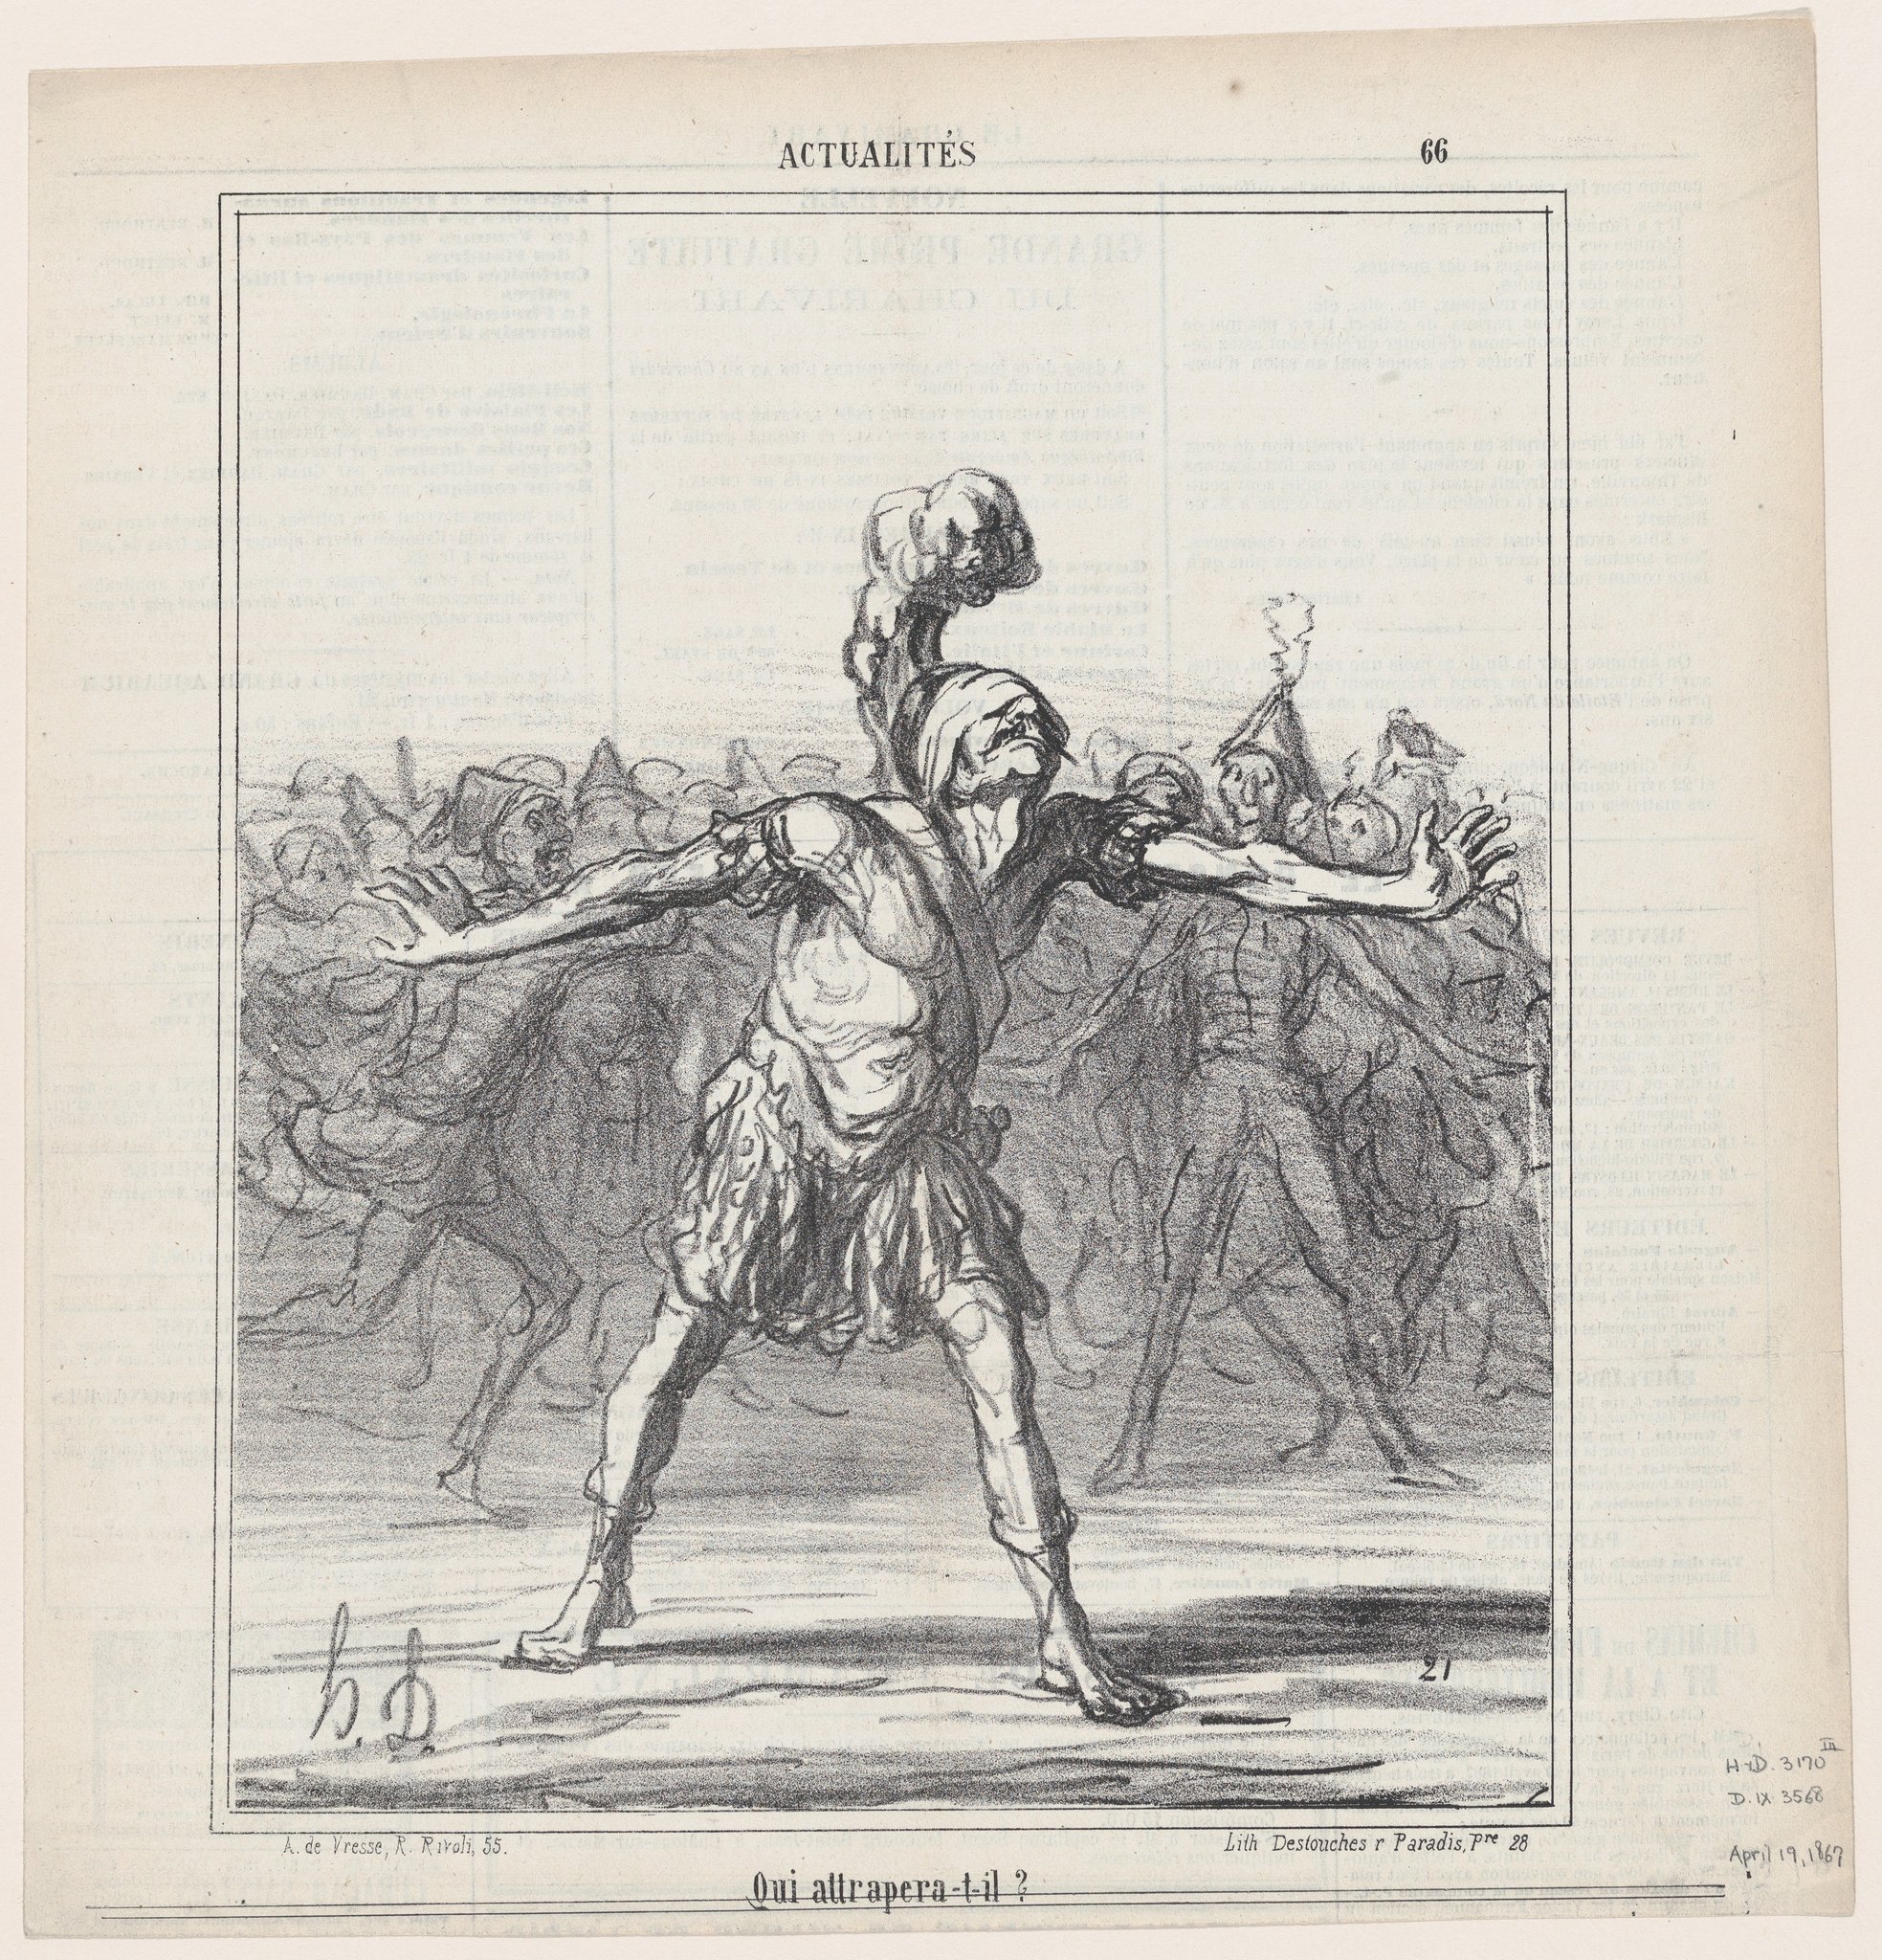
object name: print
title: Who will he catch?, from "News of the day"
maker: honoré daumier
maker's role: artist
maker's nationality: french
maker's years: 1808-1879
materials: paper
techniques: lithograph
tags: men,playing,crowd